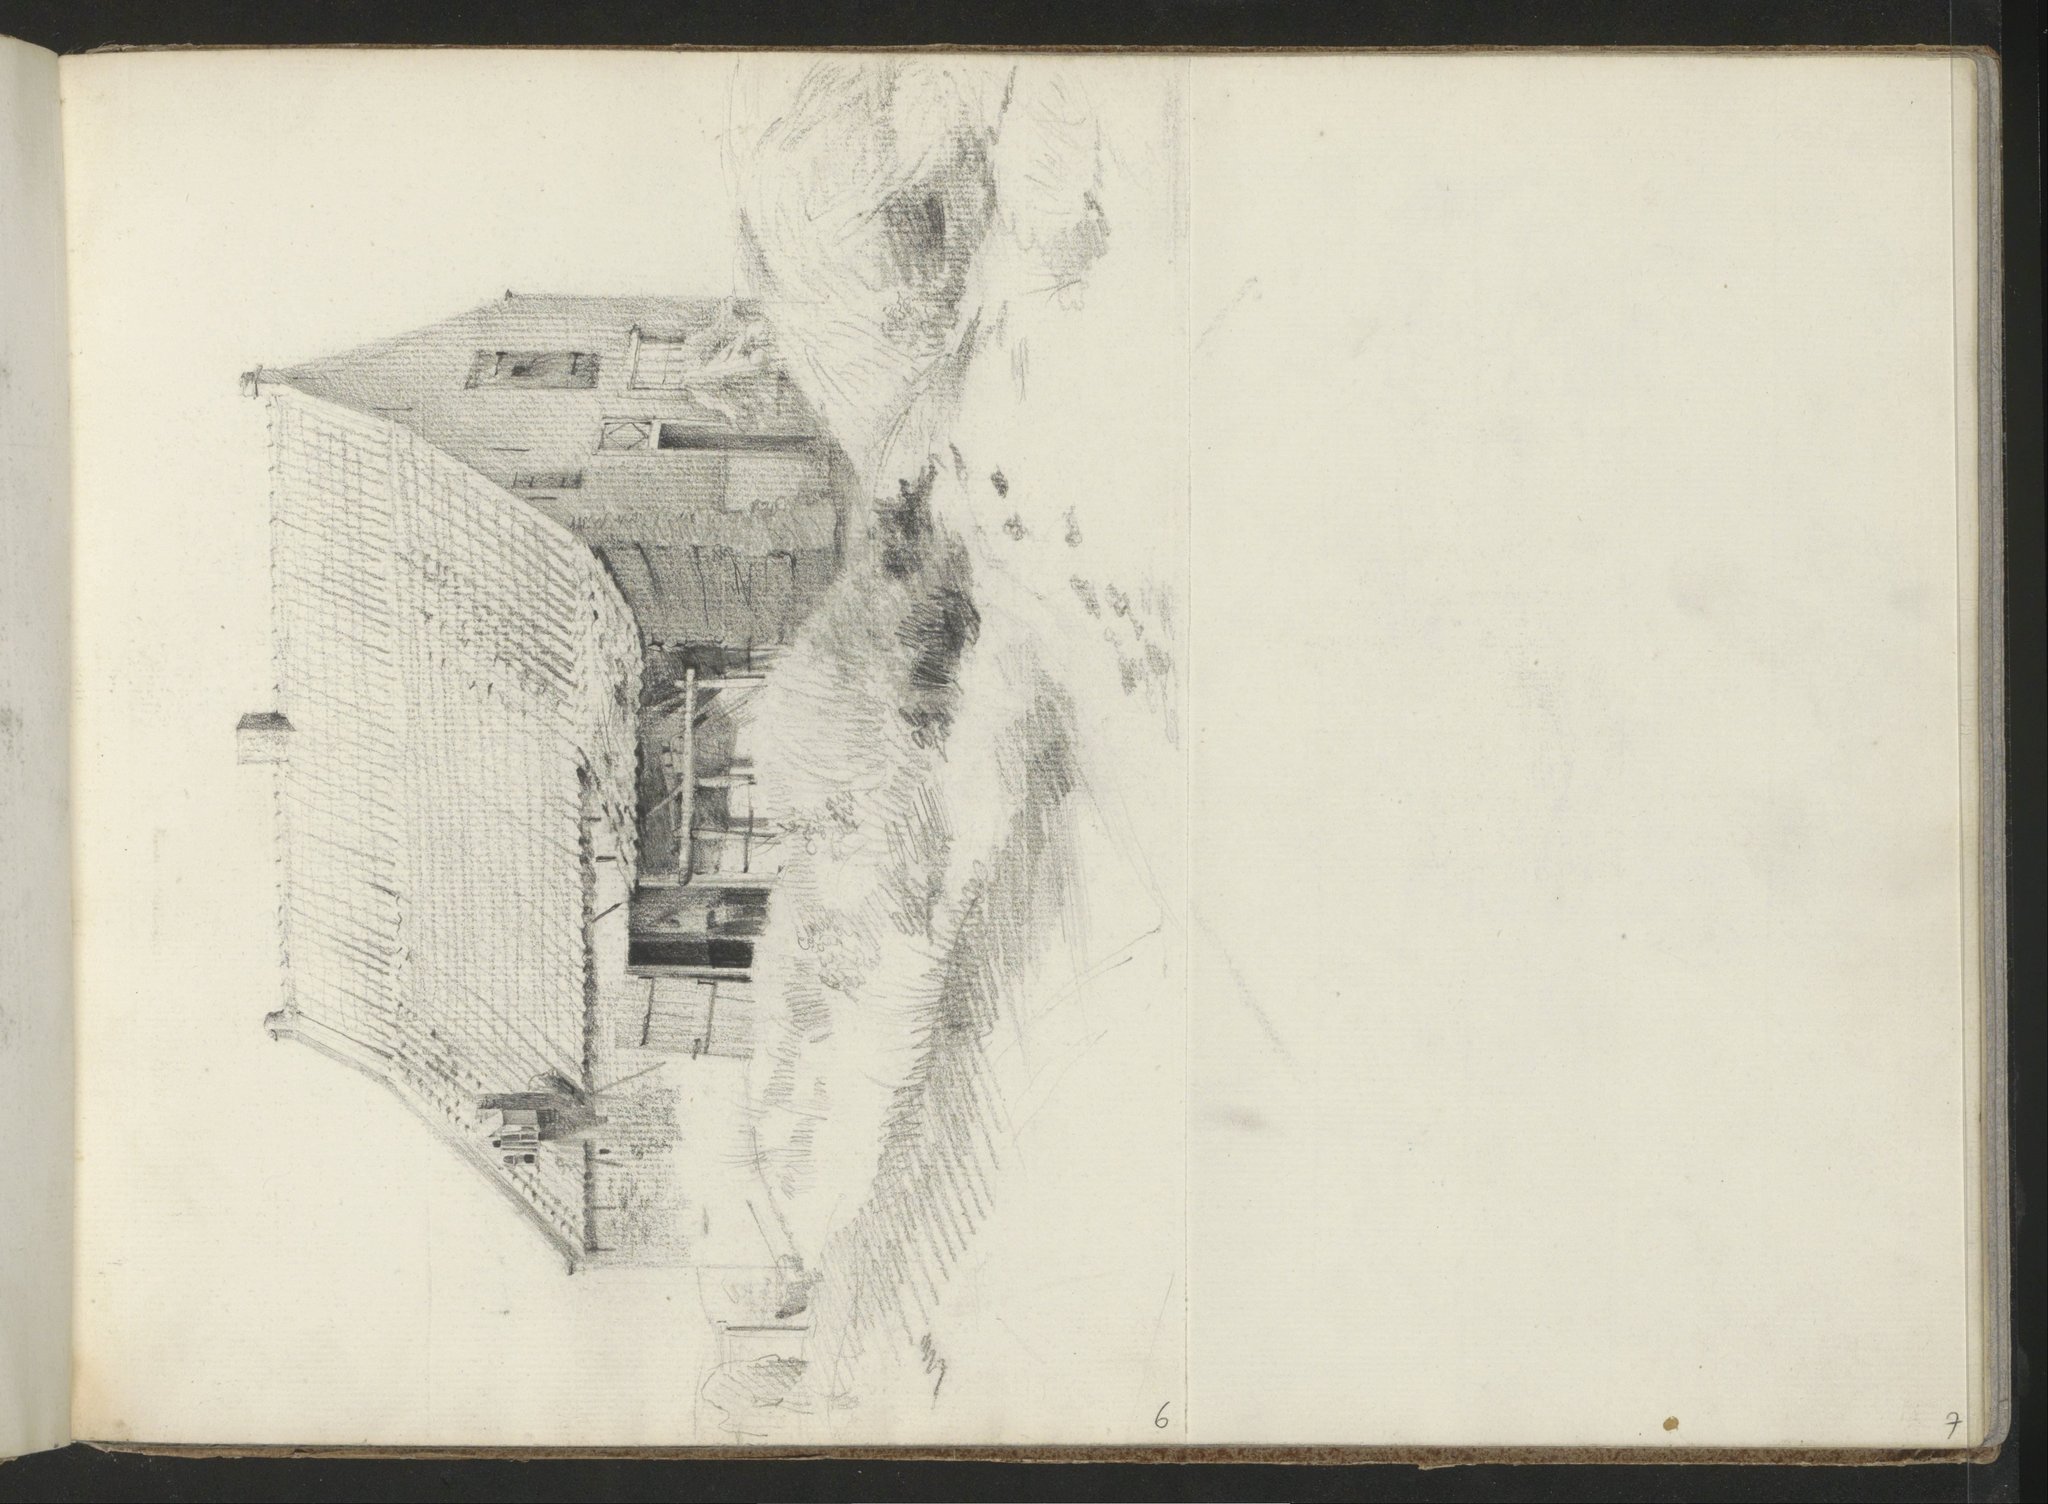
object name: sketchbook leaf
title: Huis op het platteland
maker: s. altmann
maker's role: painter, print maker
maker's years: 1822-1890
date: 1803-1840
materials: paper, pencil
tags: farm or solitary house in landscape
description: Blad 6 recto uit een schetsboek met 24 bladen.